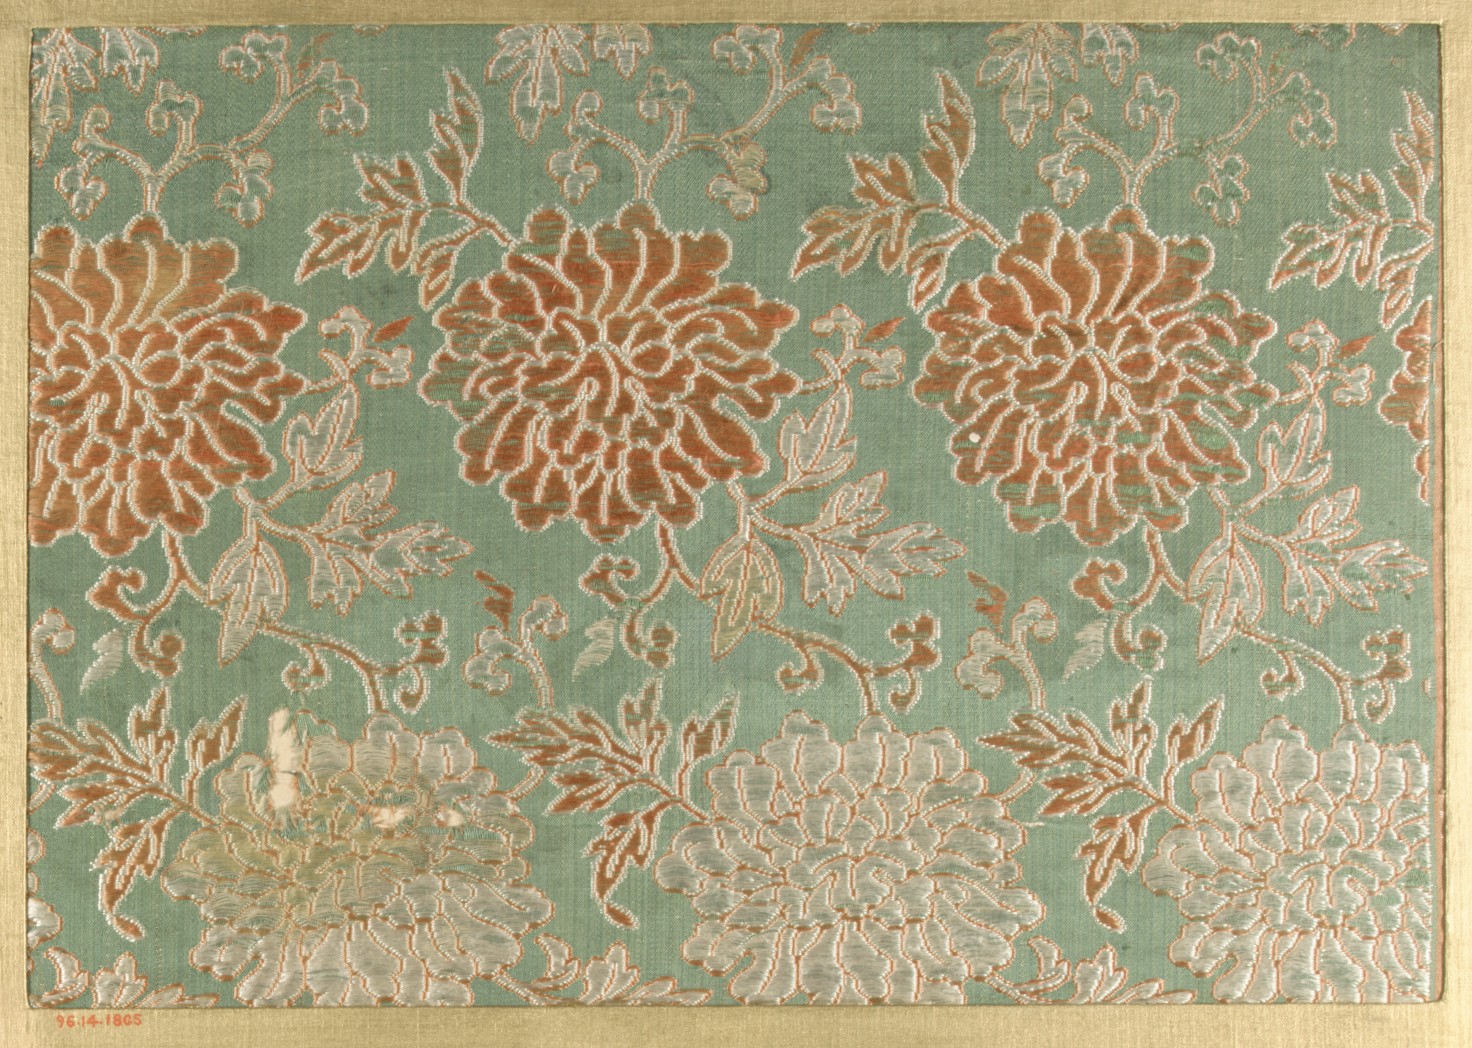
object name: piece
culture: japanese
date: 1701-1900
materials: silk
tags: leaves